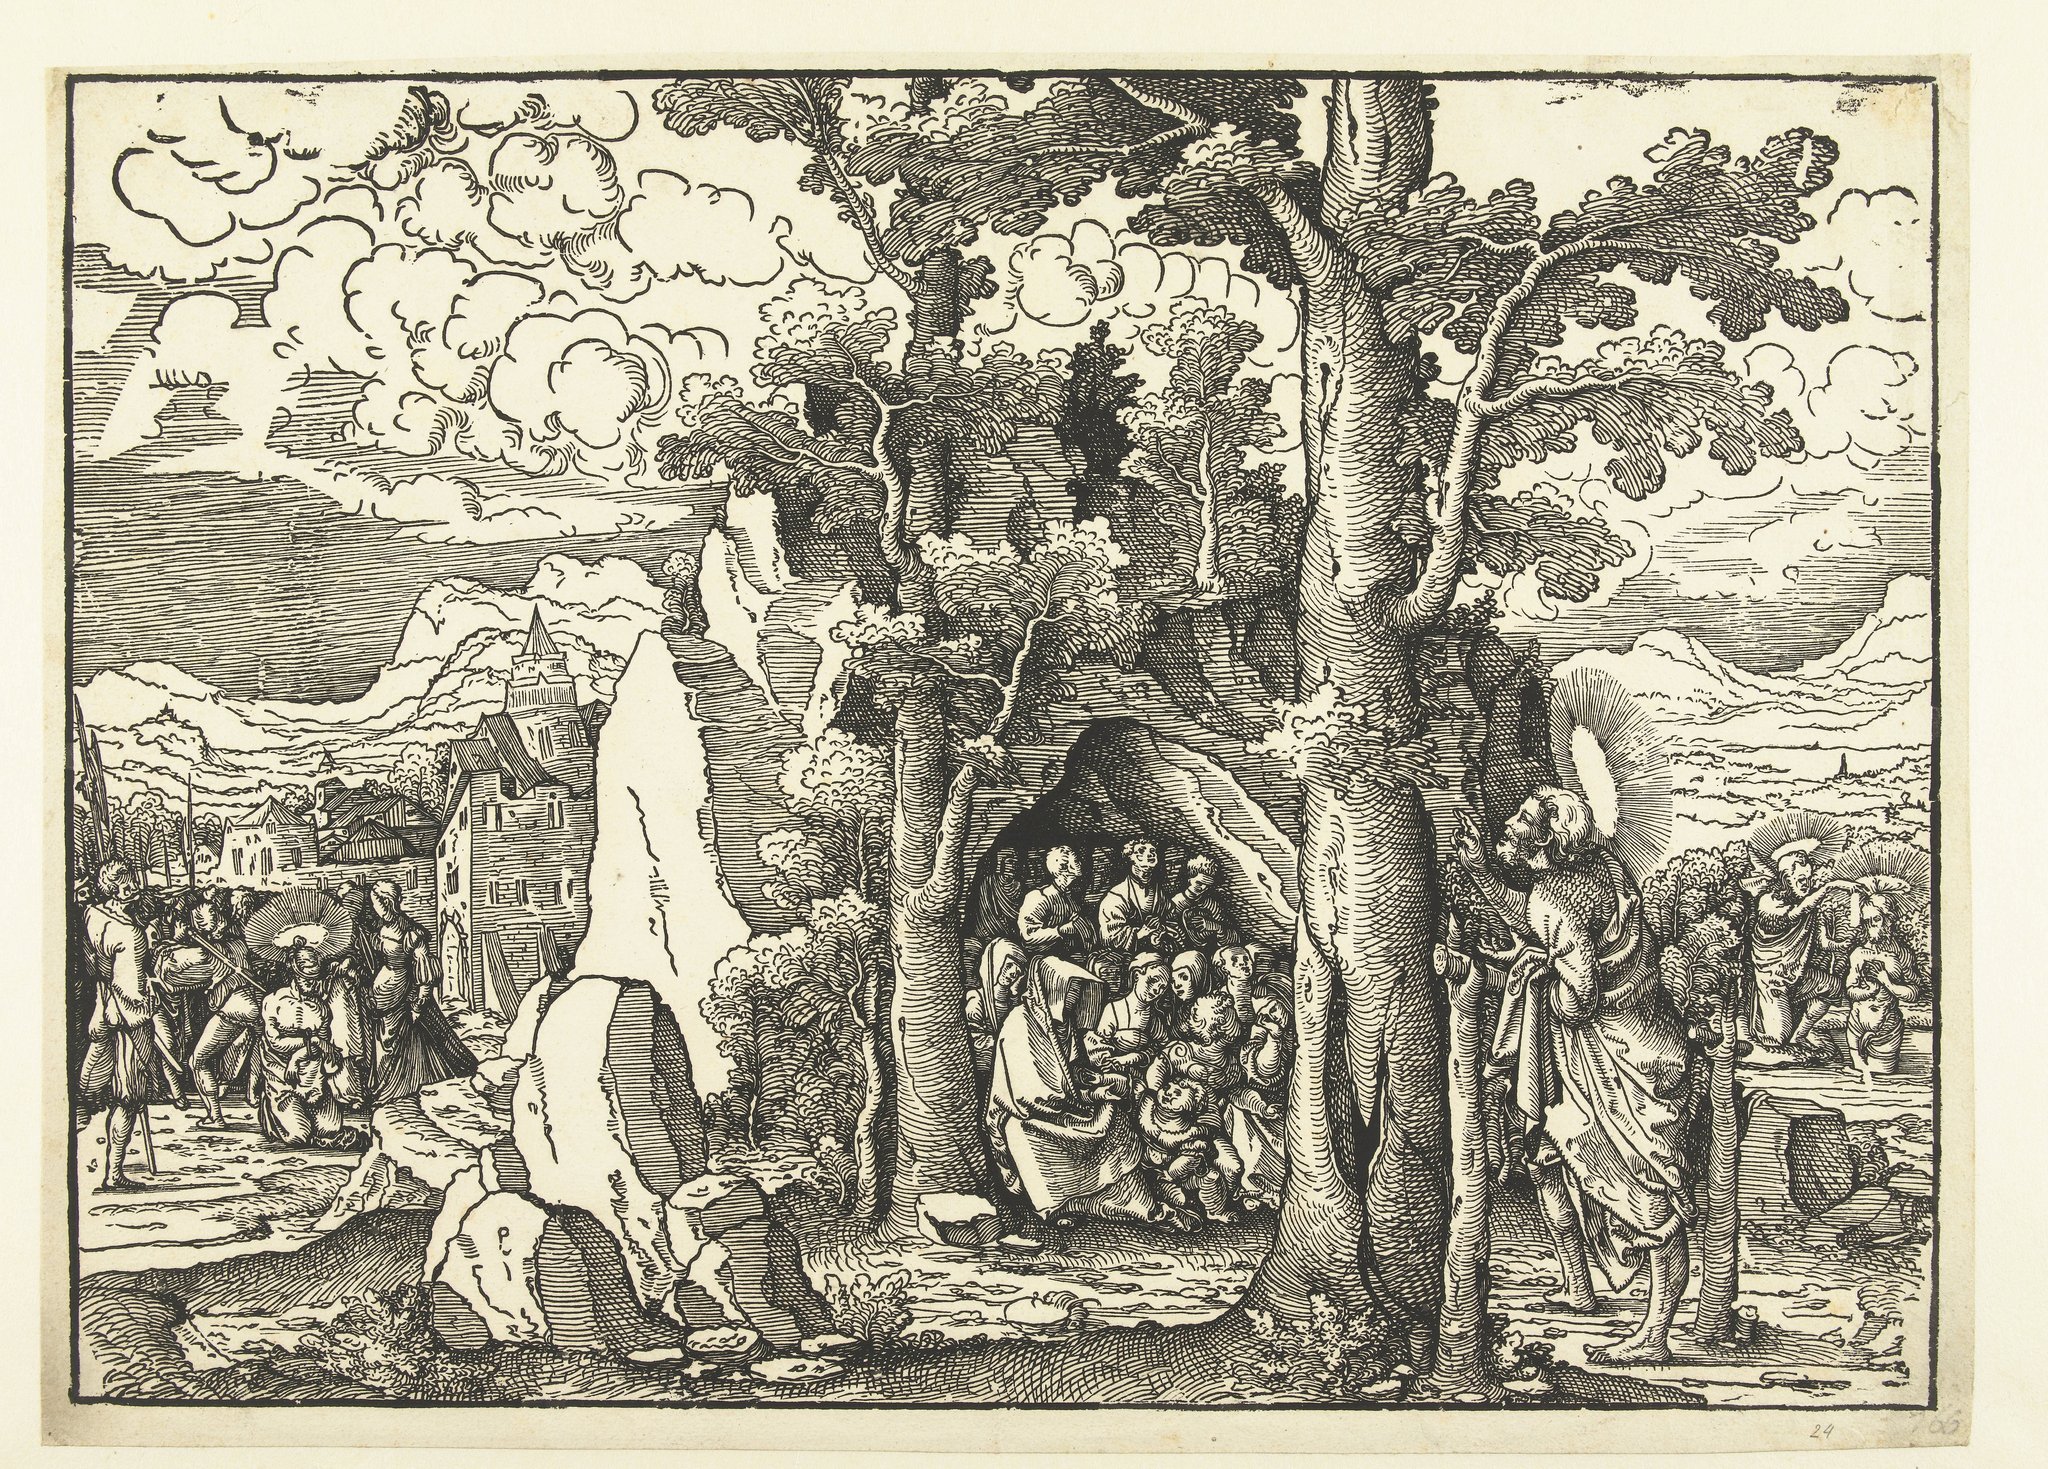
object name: print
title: Prediking van Johannes de Doper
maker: frans crabbe van espleghem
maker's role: print maker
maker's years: 1480-1552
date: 1520-1530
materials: paper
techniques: woodcut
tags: baptism of christ in the river jordan: john the baptist pouring out water on christ's head: the holy ghost descends, john the baptist preaching (perhaps christ among the bystanders), the beheading of john the baptist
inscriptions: collector's mark: Lugt 240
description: Drie scènes uit het leven van Johannes de Doper. In het midden de prediking van Johannes, de luisterende meningte zittend in een grot. In het landschap op de achtergrond de onthoofding van Johannes en de doop van Christus in de Jordaan.